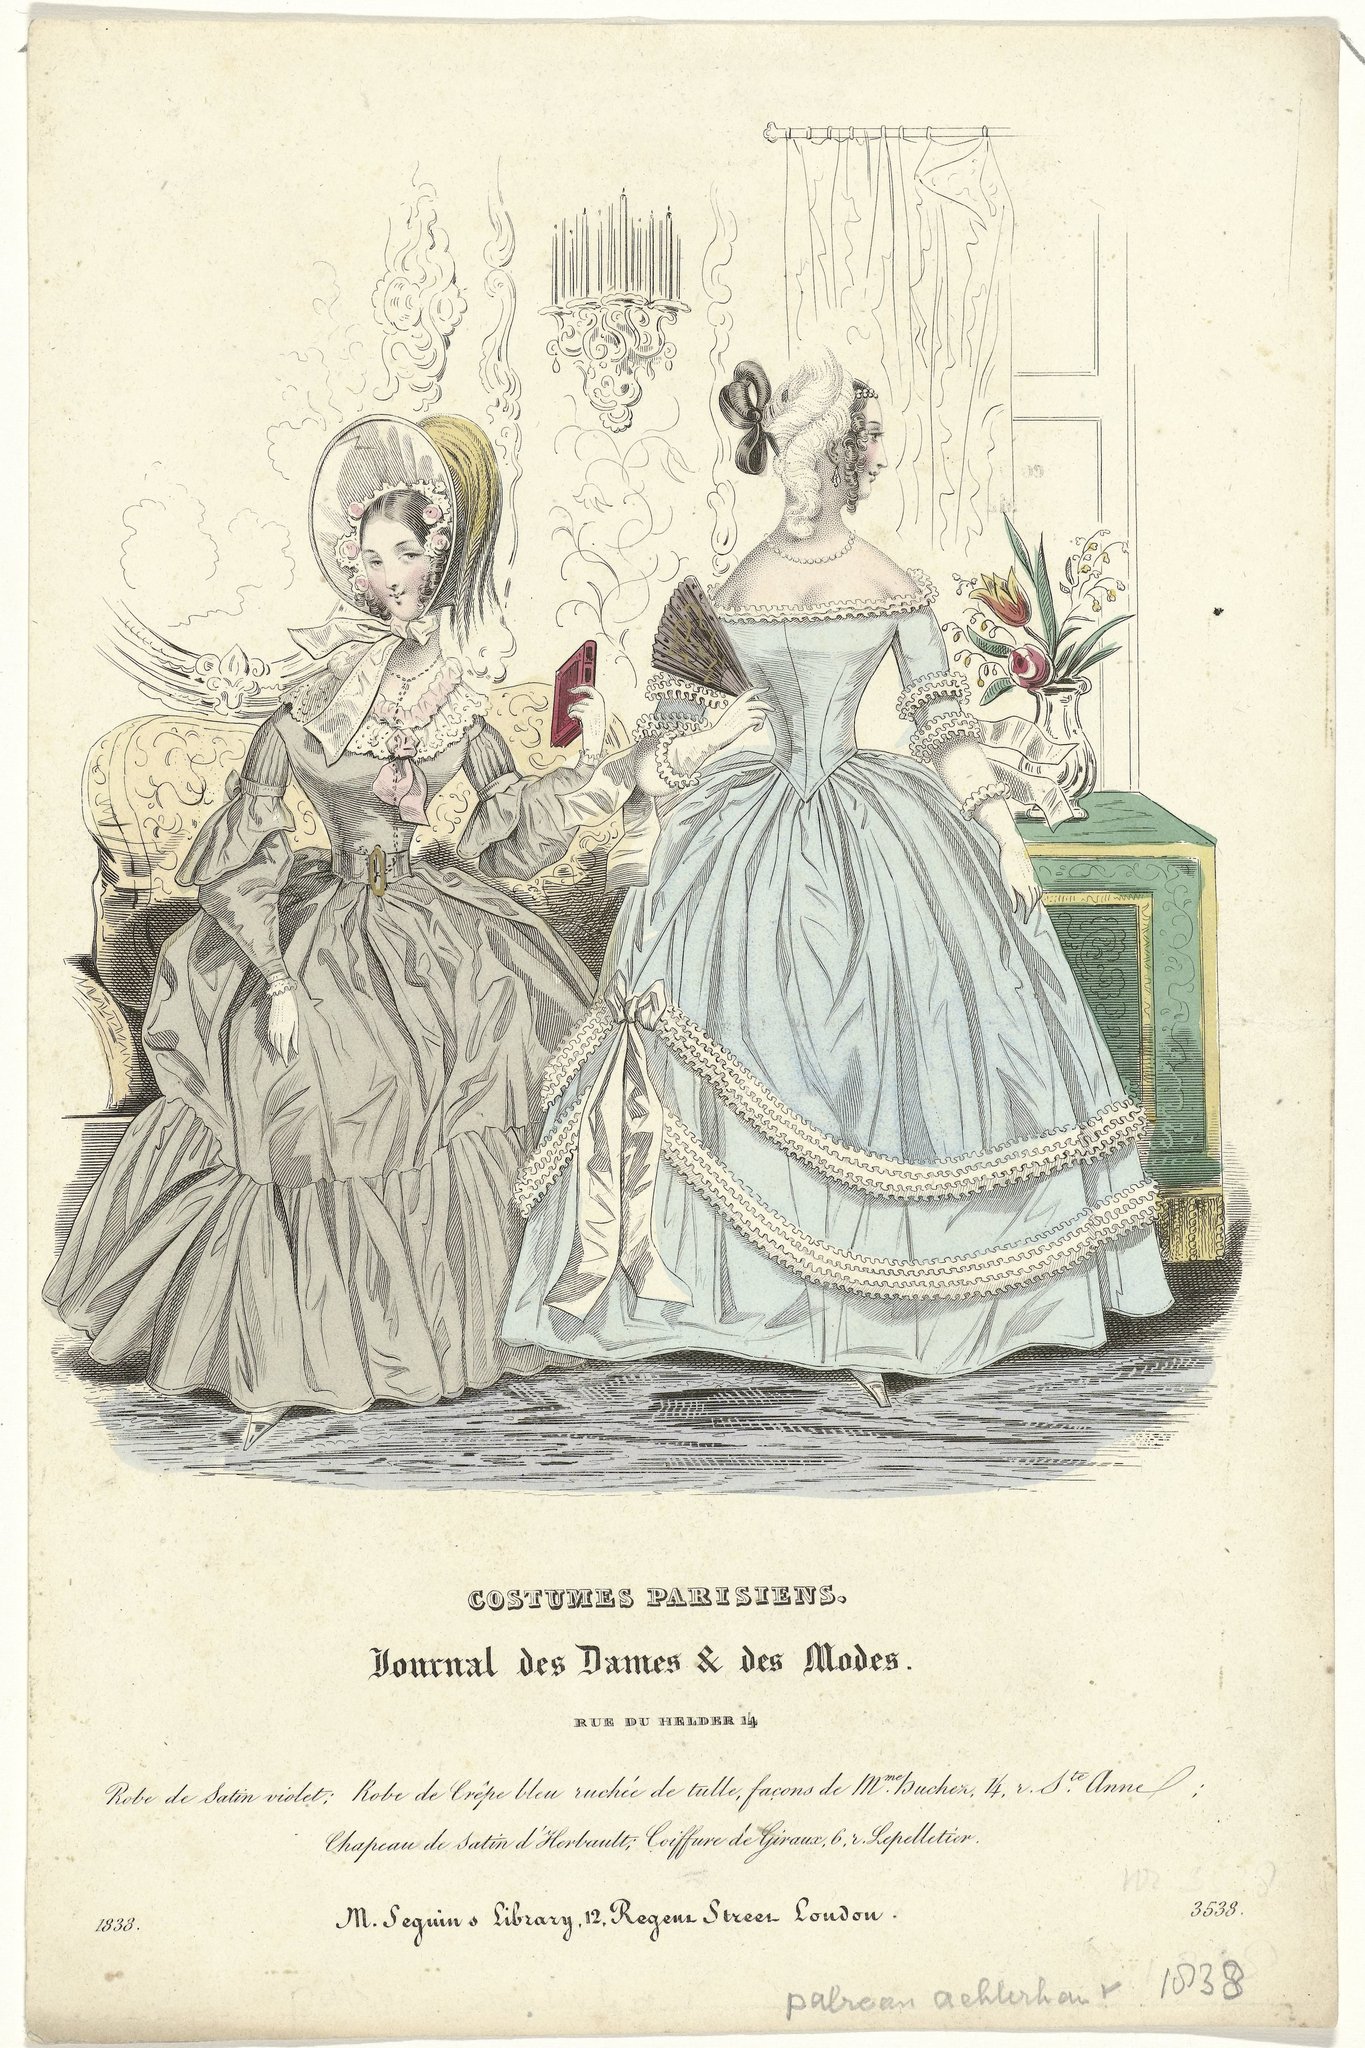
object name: fashion print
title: Journal des Dames et des Modes, Costumes Parisiens, 1838, (3538): Robe de satin violet (...)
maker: Anonymous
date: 1838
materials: paper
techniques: engraving, hand coloring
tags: ear-rings (+ women's clothes), gloves, mittens (long gloves) (+ women's clothes), head-gear: cap (+ women's clothes), fashion plates, shoes, sandals (+ women's clothes), dress, gown (+ women's clothes), book, interior of the house, fan (+ women's clothes), necklace (+ women's clothes)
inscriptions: address: ‘Reu de Helder 14 / M. Seguin a Library, 12, Regent Street London.’, inscription: ‘Pantalon sans ceinture a sous pieds Cambrés / Collet Schall / Bonnet gothique sans pattes / Corsage d'un robe Polonaise ajustant sans nervures’, caption: ‘Robe de Satin violet: Robe de Crêpe bleu ruchée de tulle, façons de M.me Hucher, 14, r. S.te Anne; Chapeau de satin d'Herbault; Coiffure de Giraux,6,r. Lepelletier.’, title: ‘Costumes Parisiens. / Journal des Dames & des Modes.’, title: ‘Journal des Dames. Rue Helder, 14.’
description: Twee vrouwen in een interieur. Links: japon van satijn. Luifelhoed van satijn van Herbault. Accessoires: collier, handschoenen, ceintuur, schoen met puntige neus. Rechts: japon van crêpe versierd met ruches van tule, door Hucher. 'Coiffure' van Giraux. Accessoires: oorbel in het rechteroor, collier, waaier, handschoenen, schoen met vierkante neus. Verso: patronen van onder andere een vest, lange broek, muts en een lijfje van een 'robe Polonaise'. De prent maakt deel uit van het modetijdschrift Journal des Dames et des Modes, Parijs, 1797-1839.